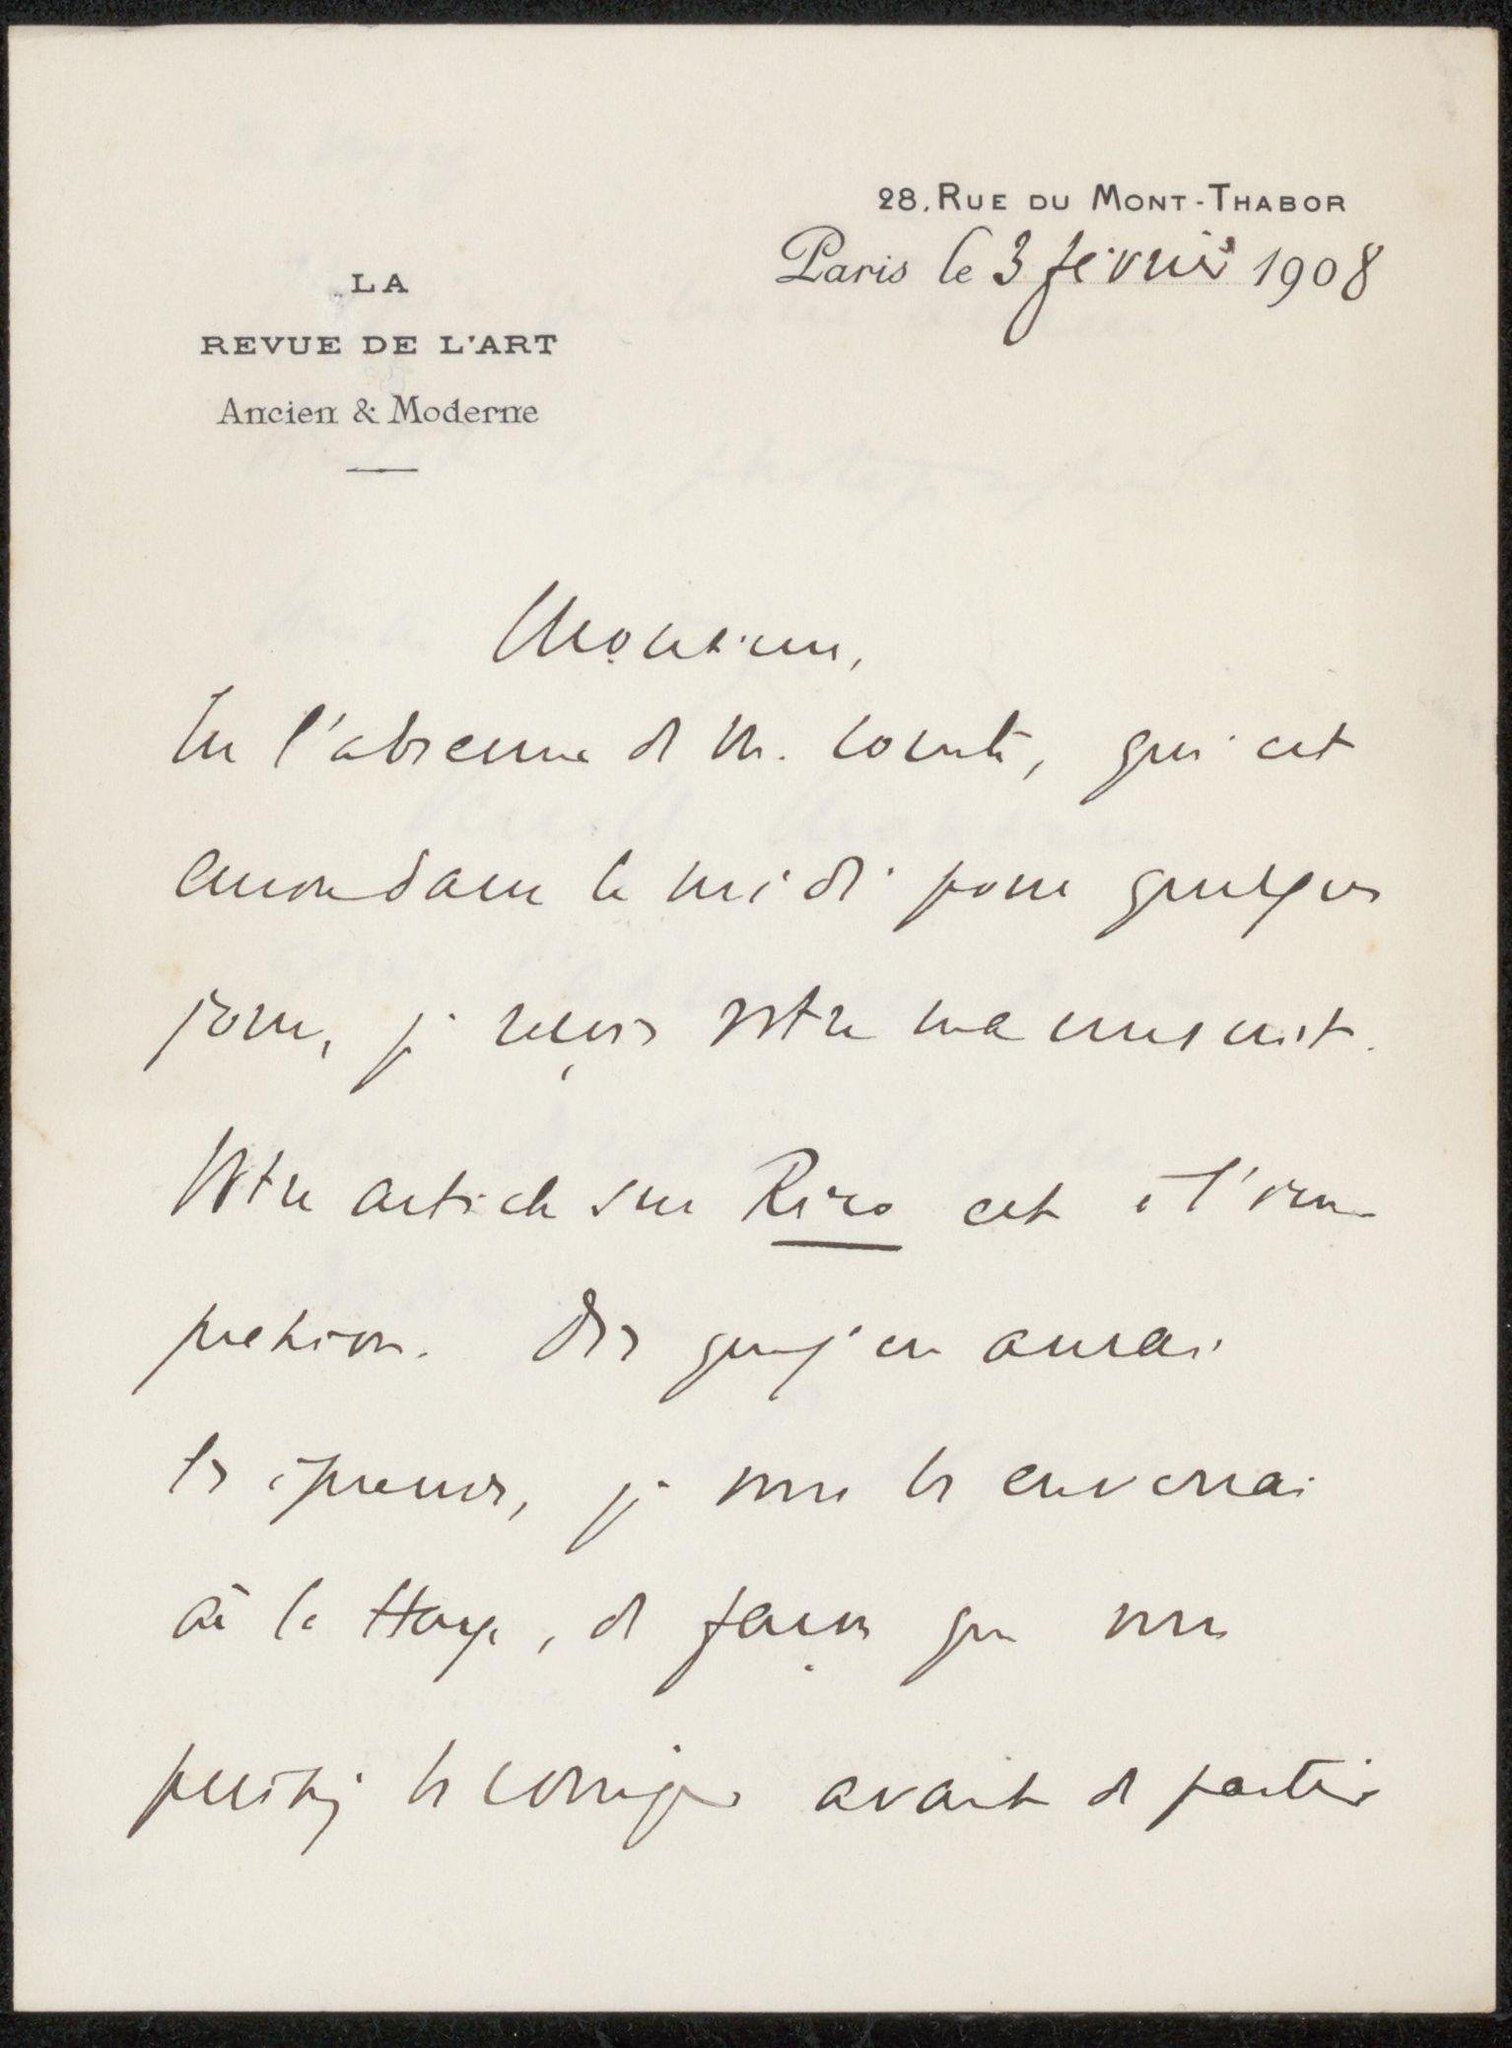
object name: letter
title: Brief aan Philip Zilcken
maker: p. alfana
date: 1908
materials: ink, paper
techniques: pen, printing, writing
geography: paris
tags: paris, draughtsman, eugène delacroix, camille corot, print maker, gustave courbet, jean françois millet, official, jules comte, venice, painter, martín rico ortega, the hague, philip zilcken, photography, cinematography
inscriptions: collector's mark: ‘RPK’, watermark